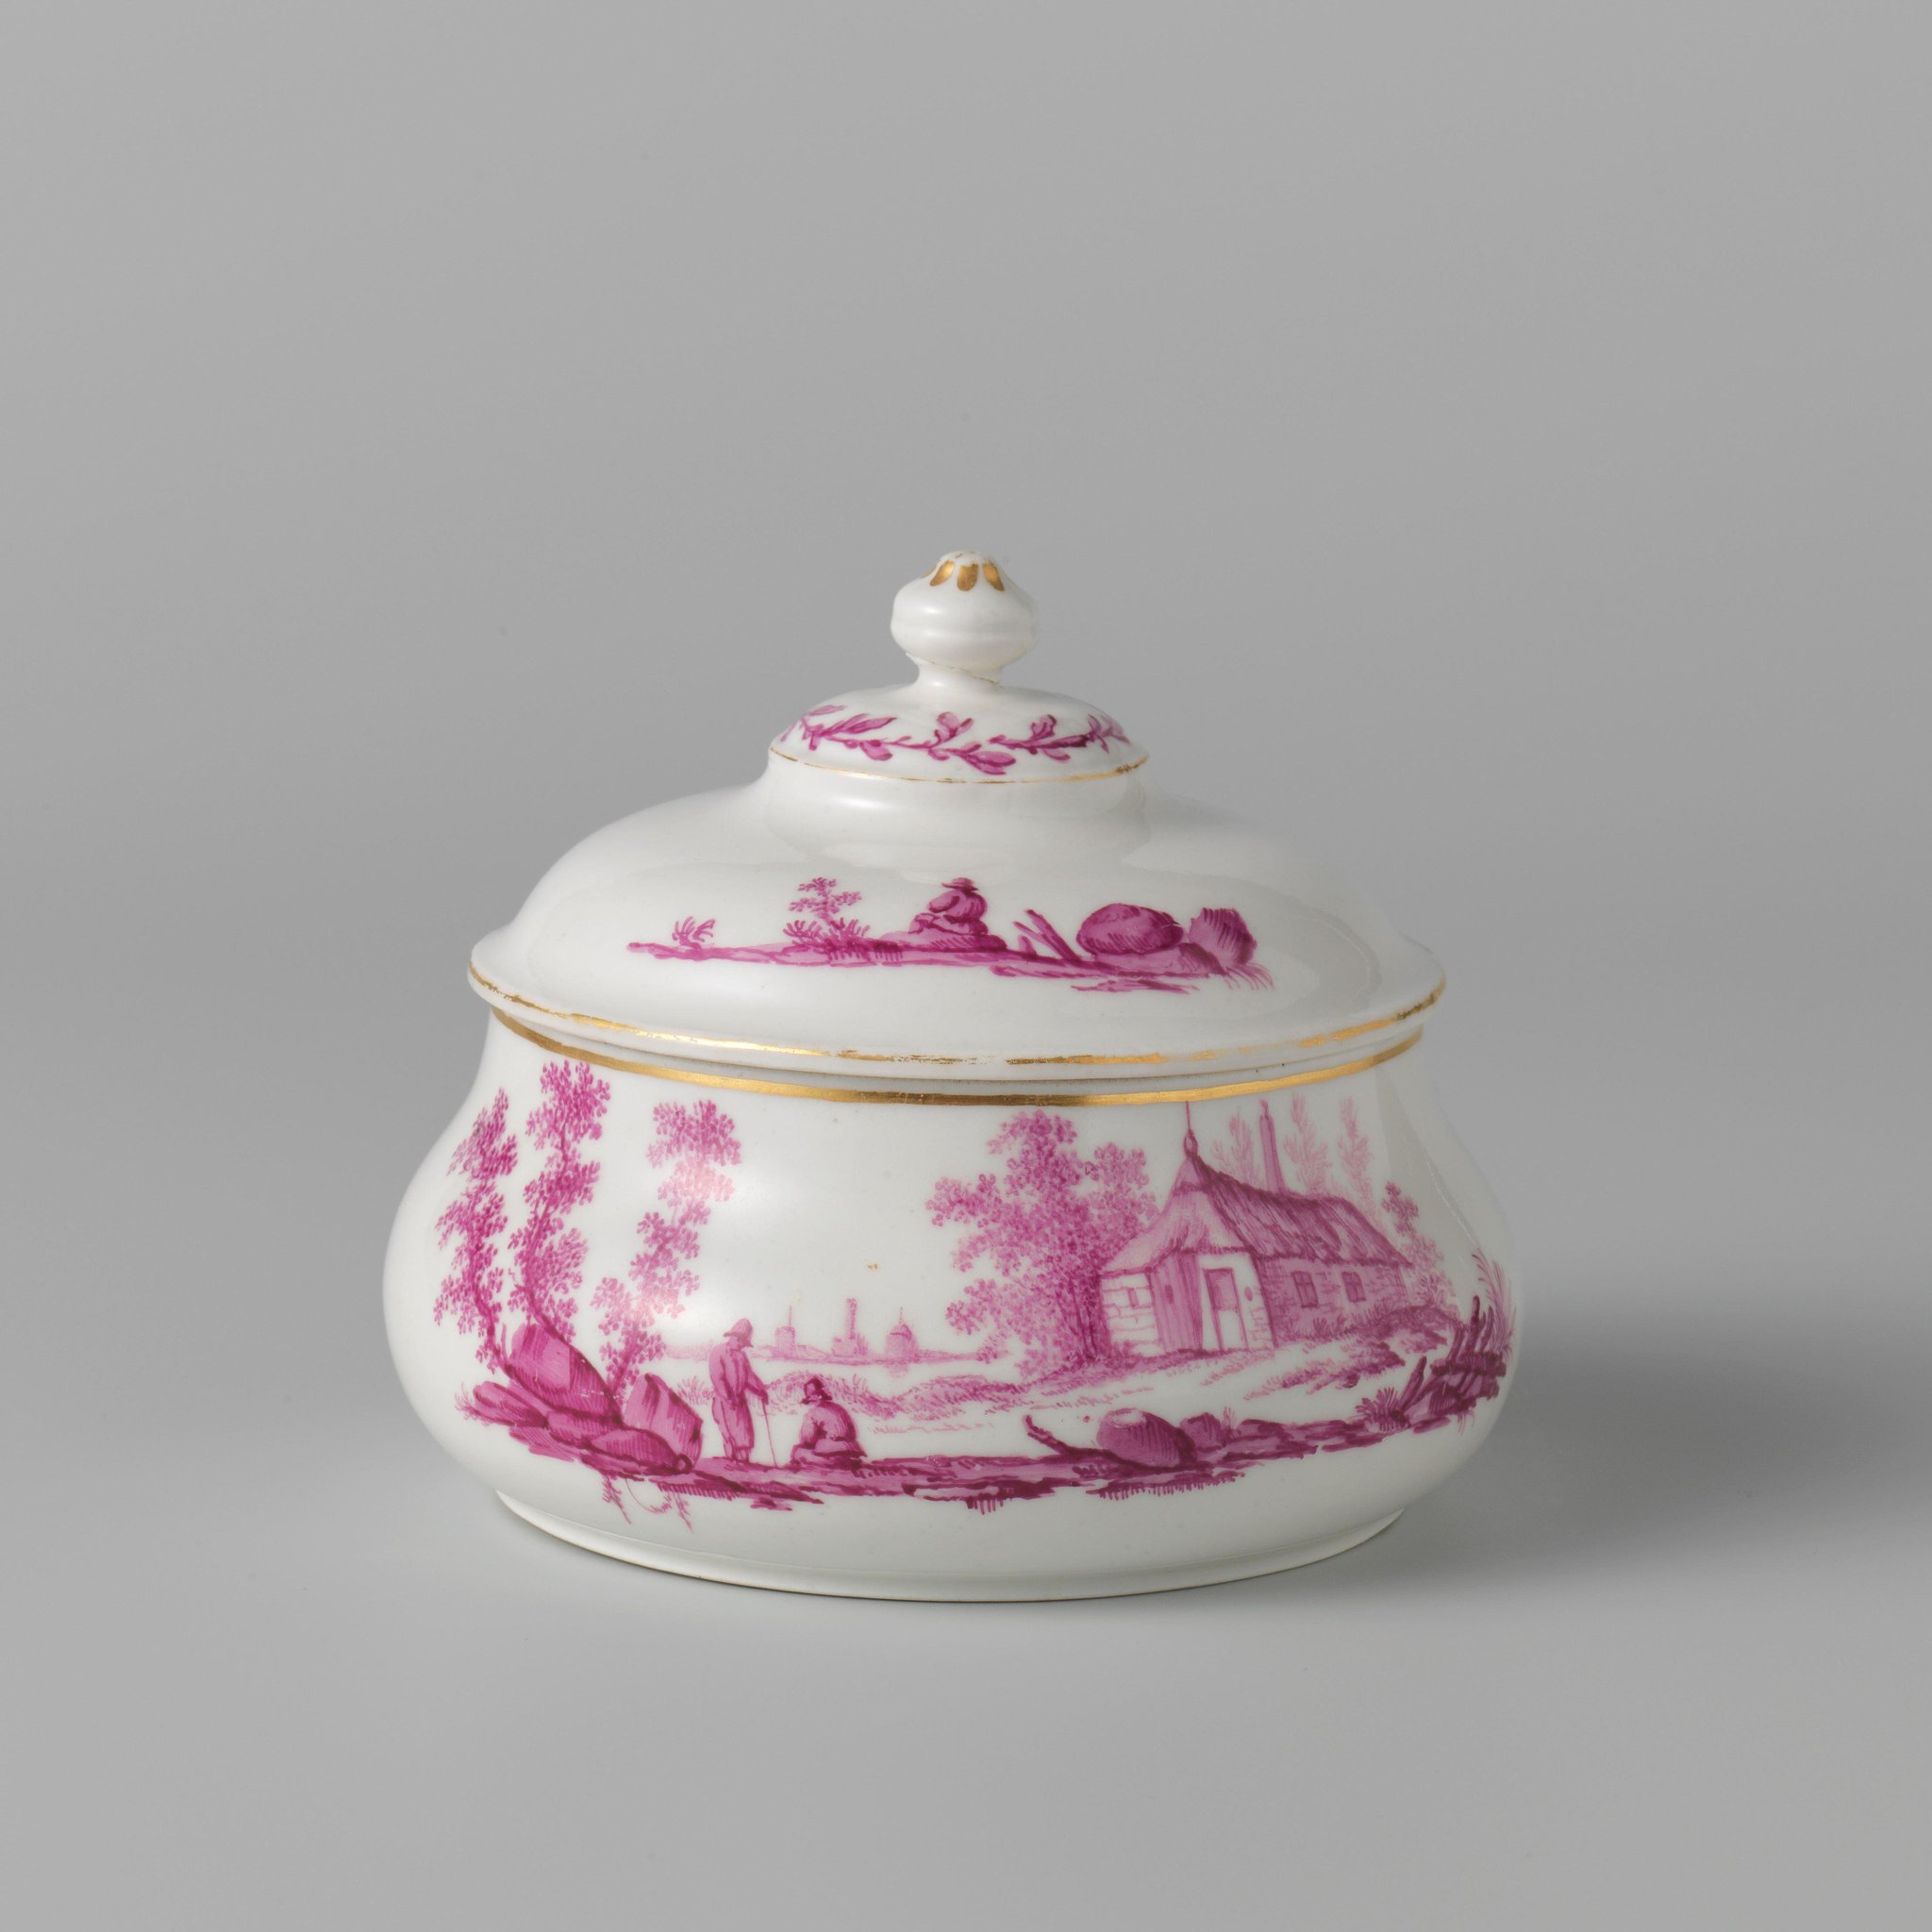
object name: tobacco jar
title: Tabakspot, beschilderd met figuren in een landschap met boerderij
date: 1774-1778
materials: porcelain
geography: loosdrecht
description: Tabakspot van porselein, beschilderd in bietenrood met figuren in een landschap met boerderij.